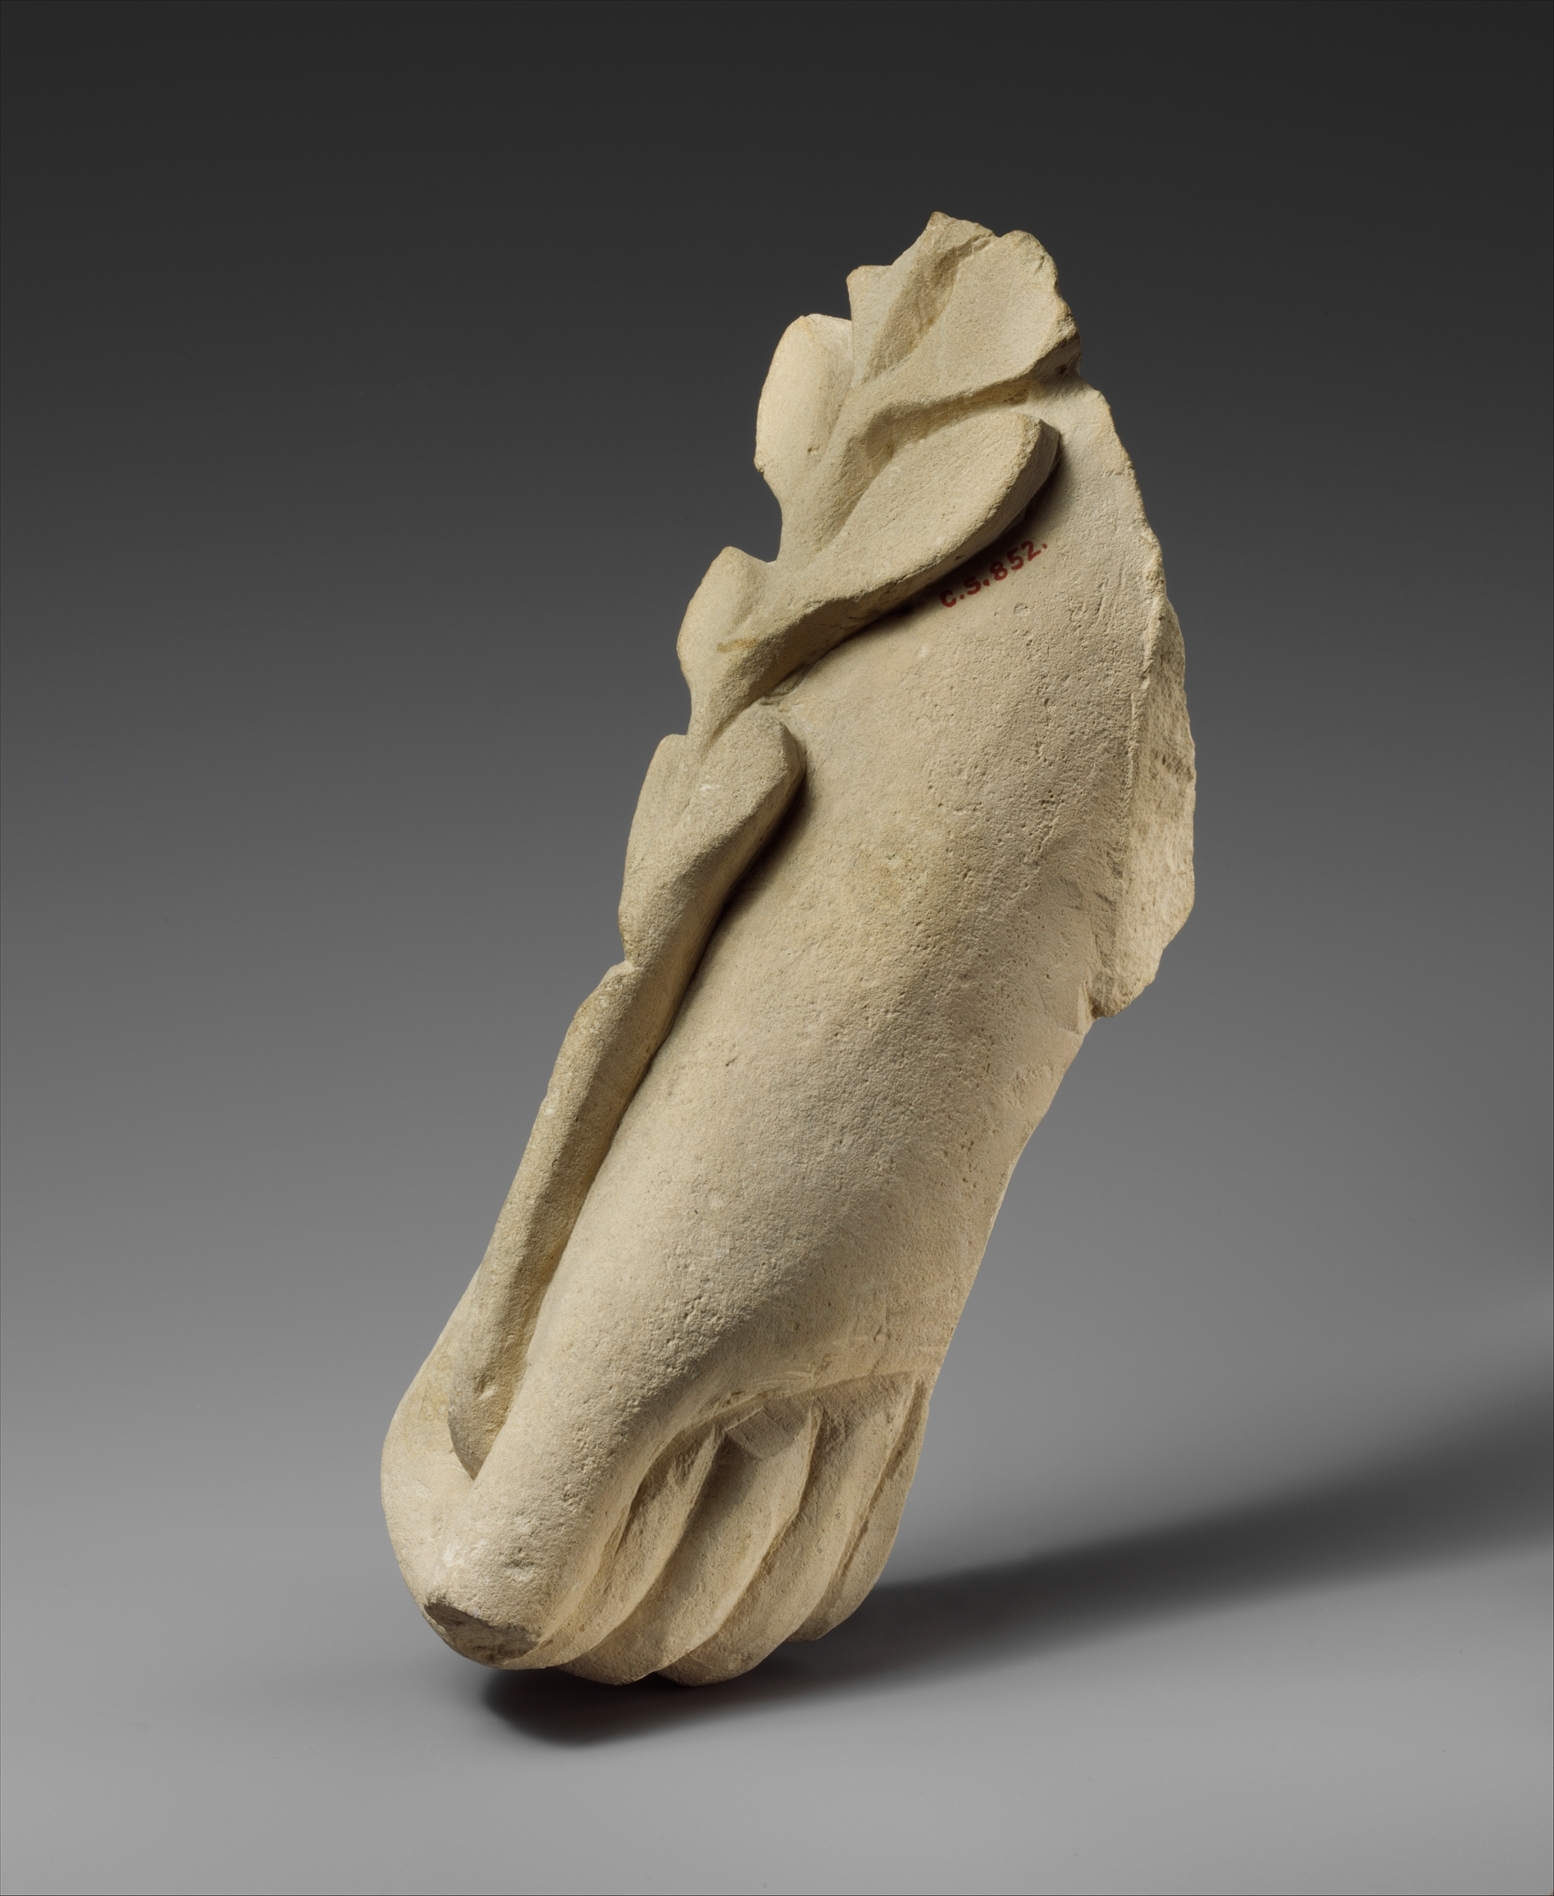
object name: hand, right, holding branch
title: Limestone hand holding a branch of leaves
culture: cypriot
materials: limestone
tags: hands,leaves